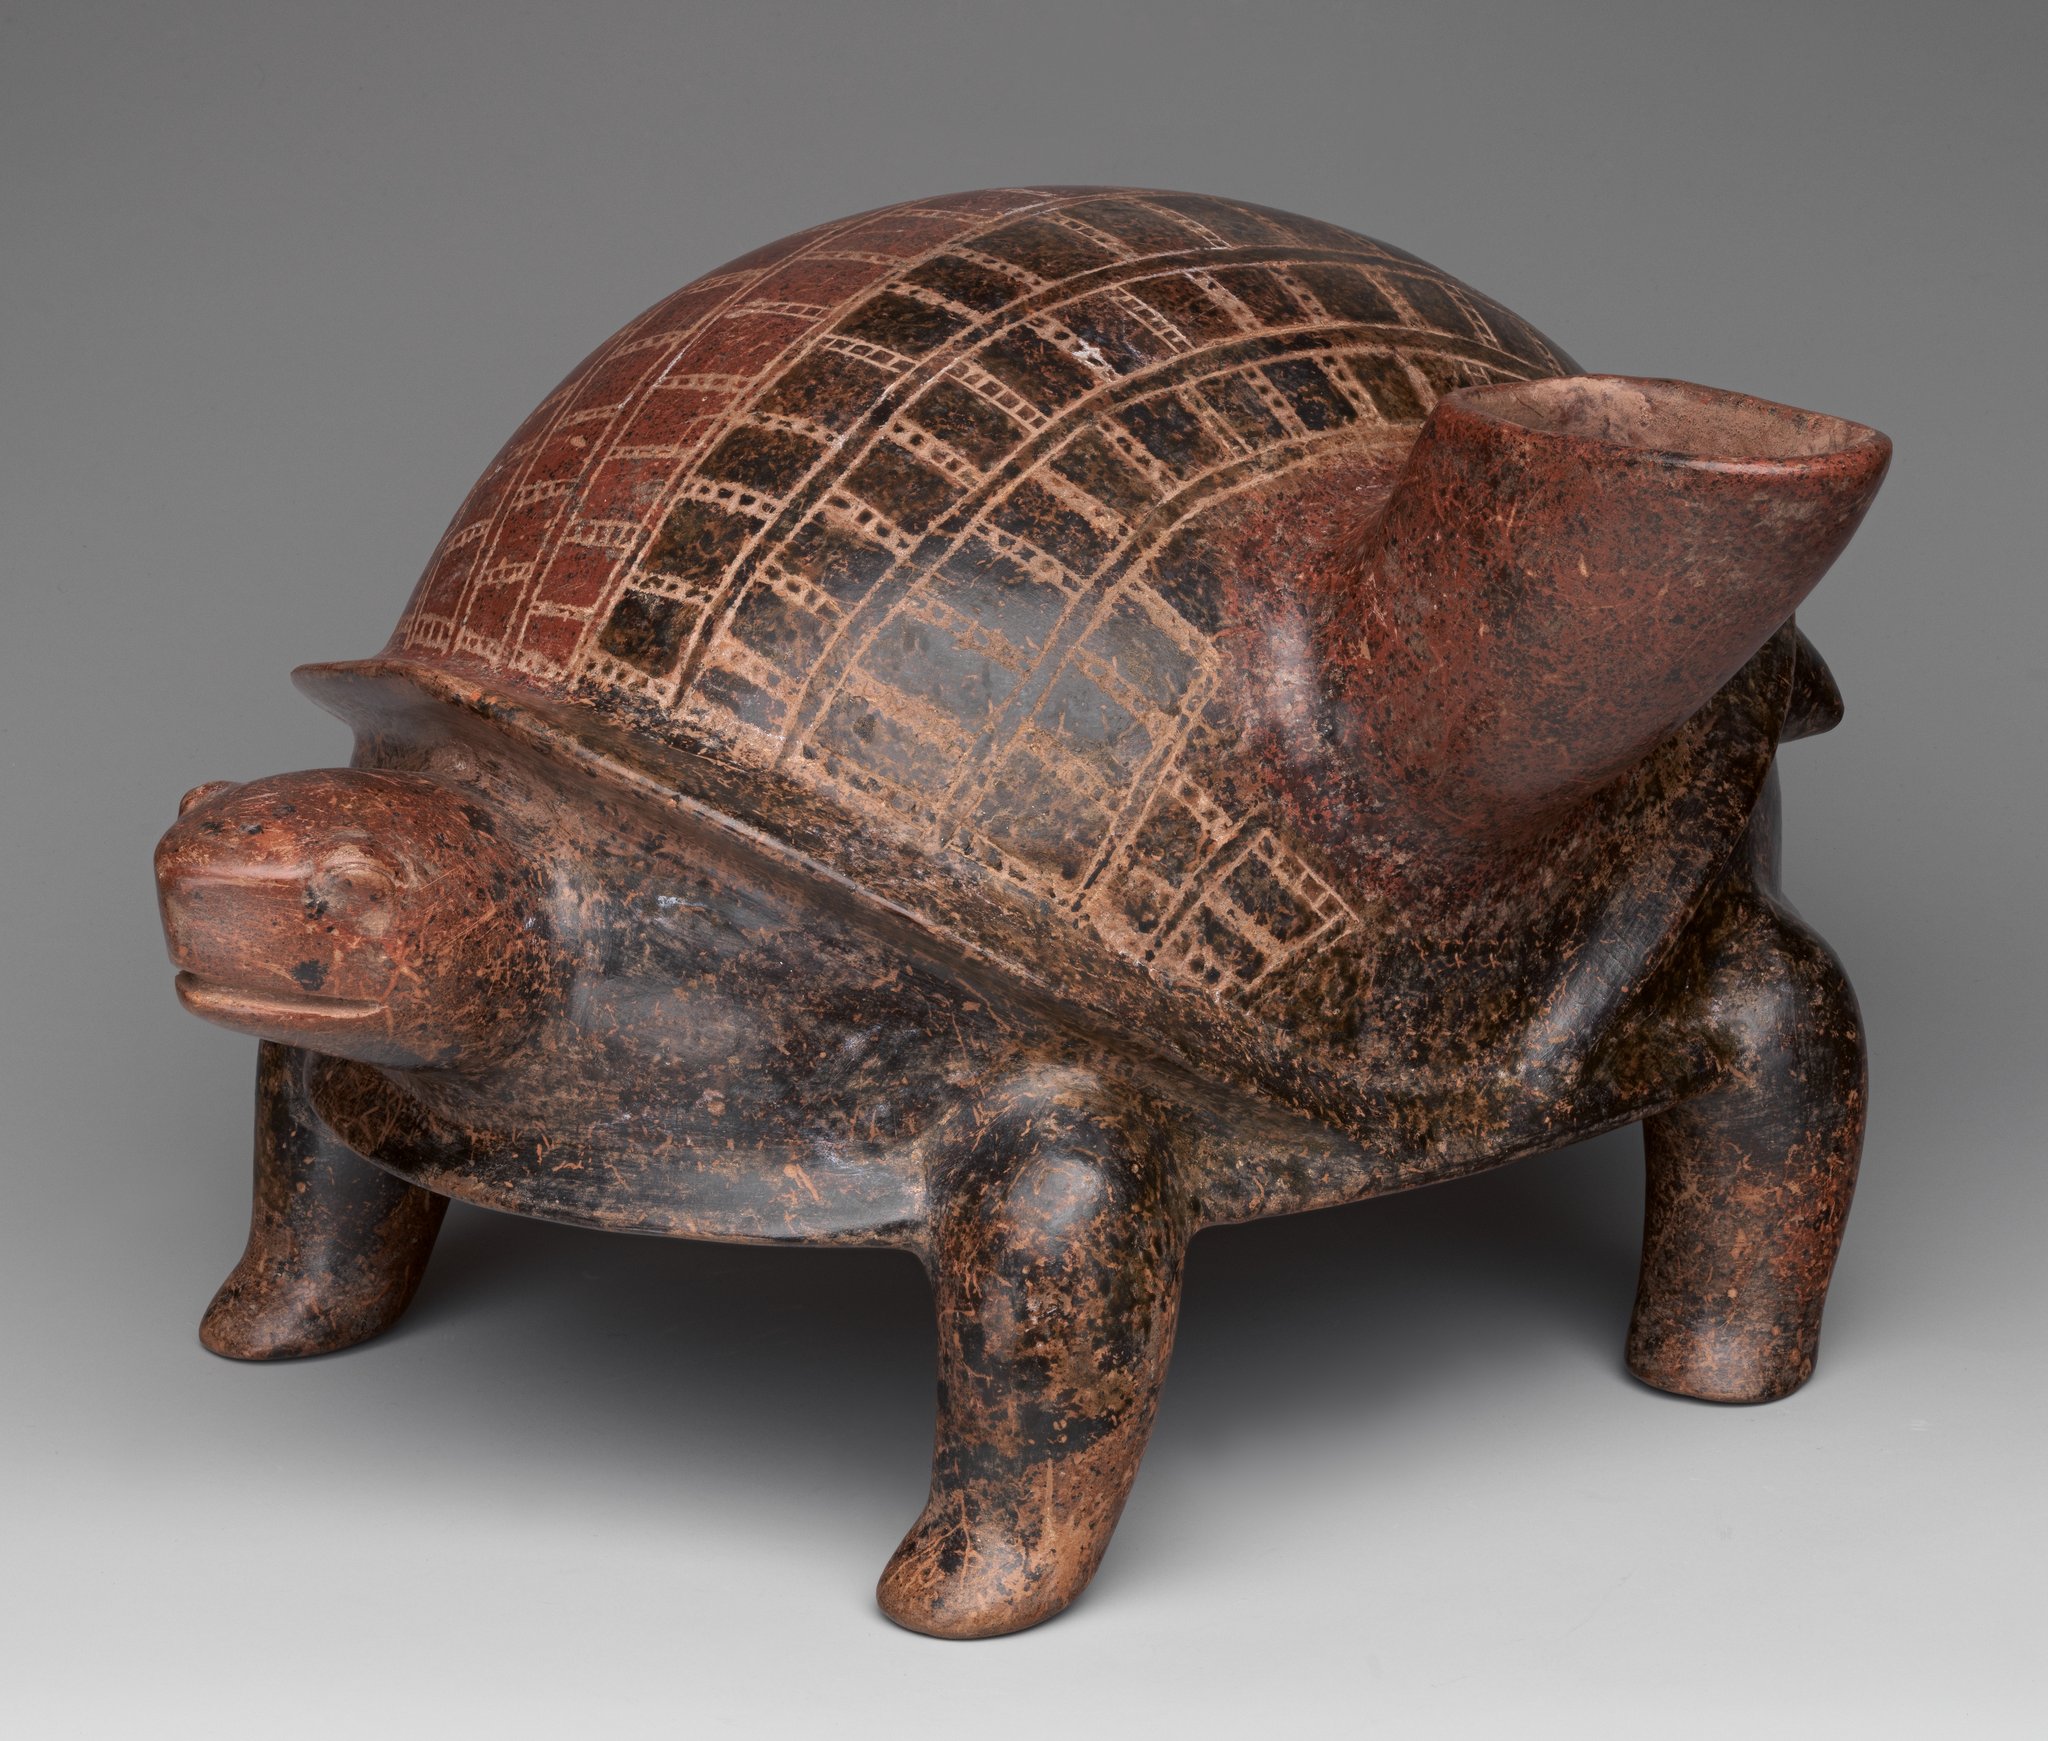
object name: vessel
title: Turtle vessel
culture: colima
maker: colima artist(s)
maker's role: artist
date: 200 BCE-300 CE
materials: ceramic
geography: west mexico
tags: turtles